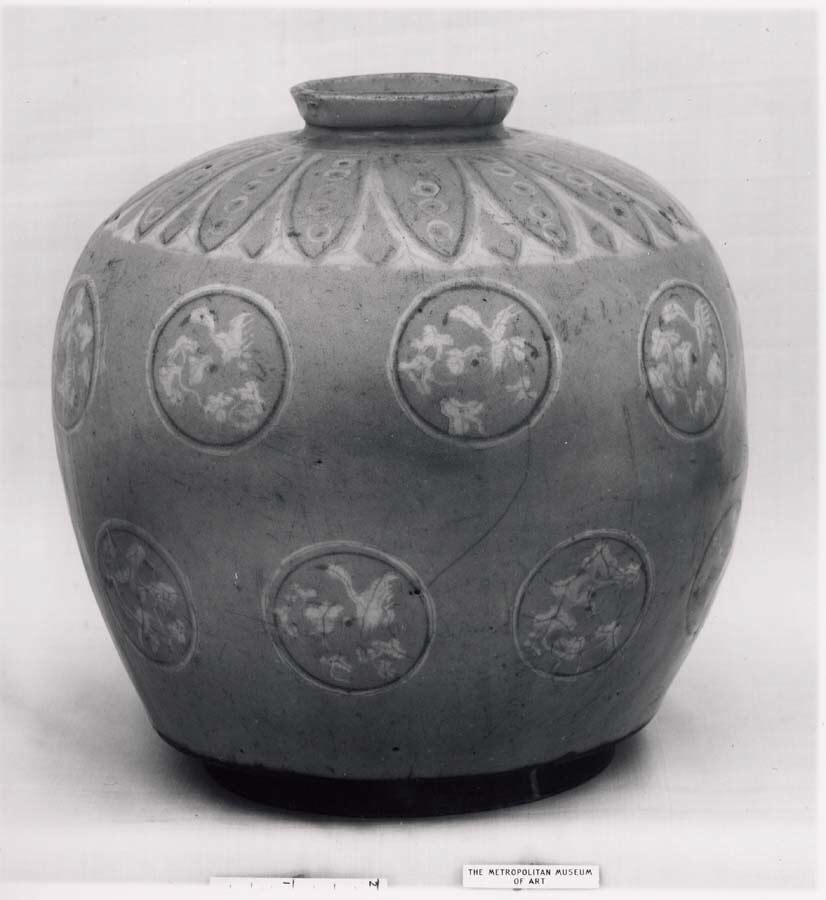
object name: vase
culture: korean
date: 1901-1933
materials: ceramic glaze, glaze, stoneware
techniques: inlay